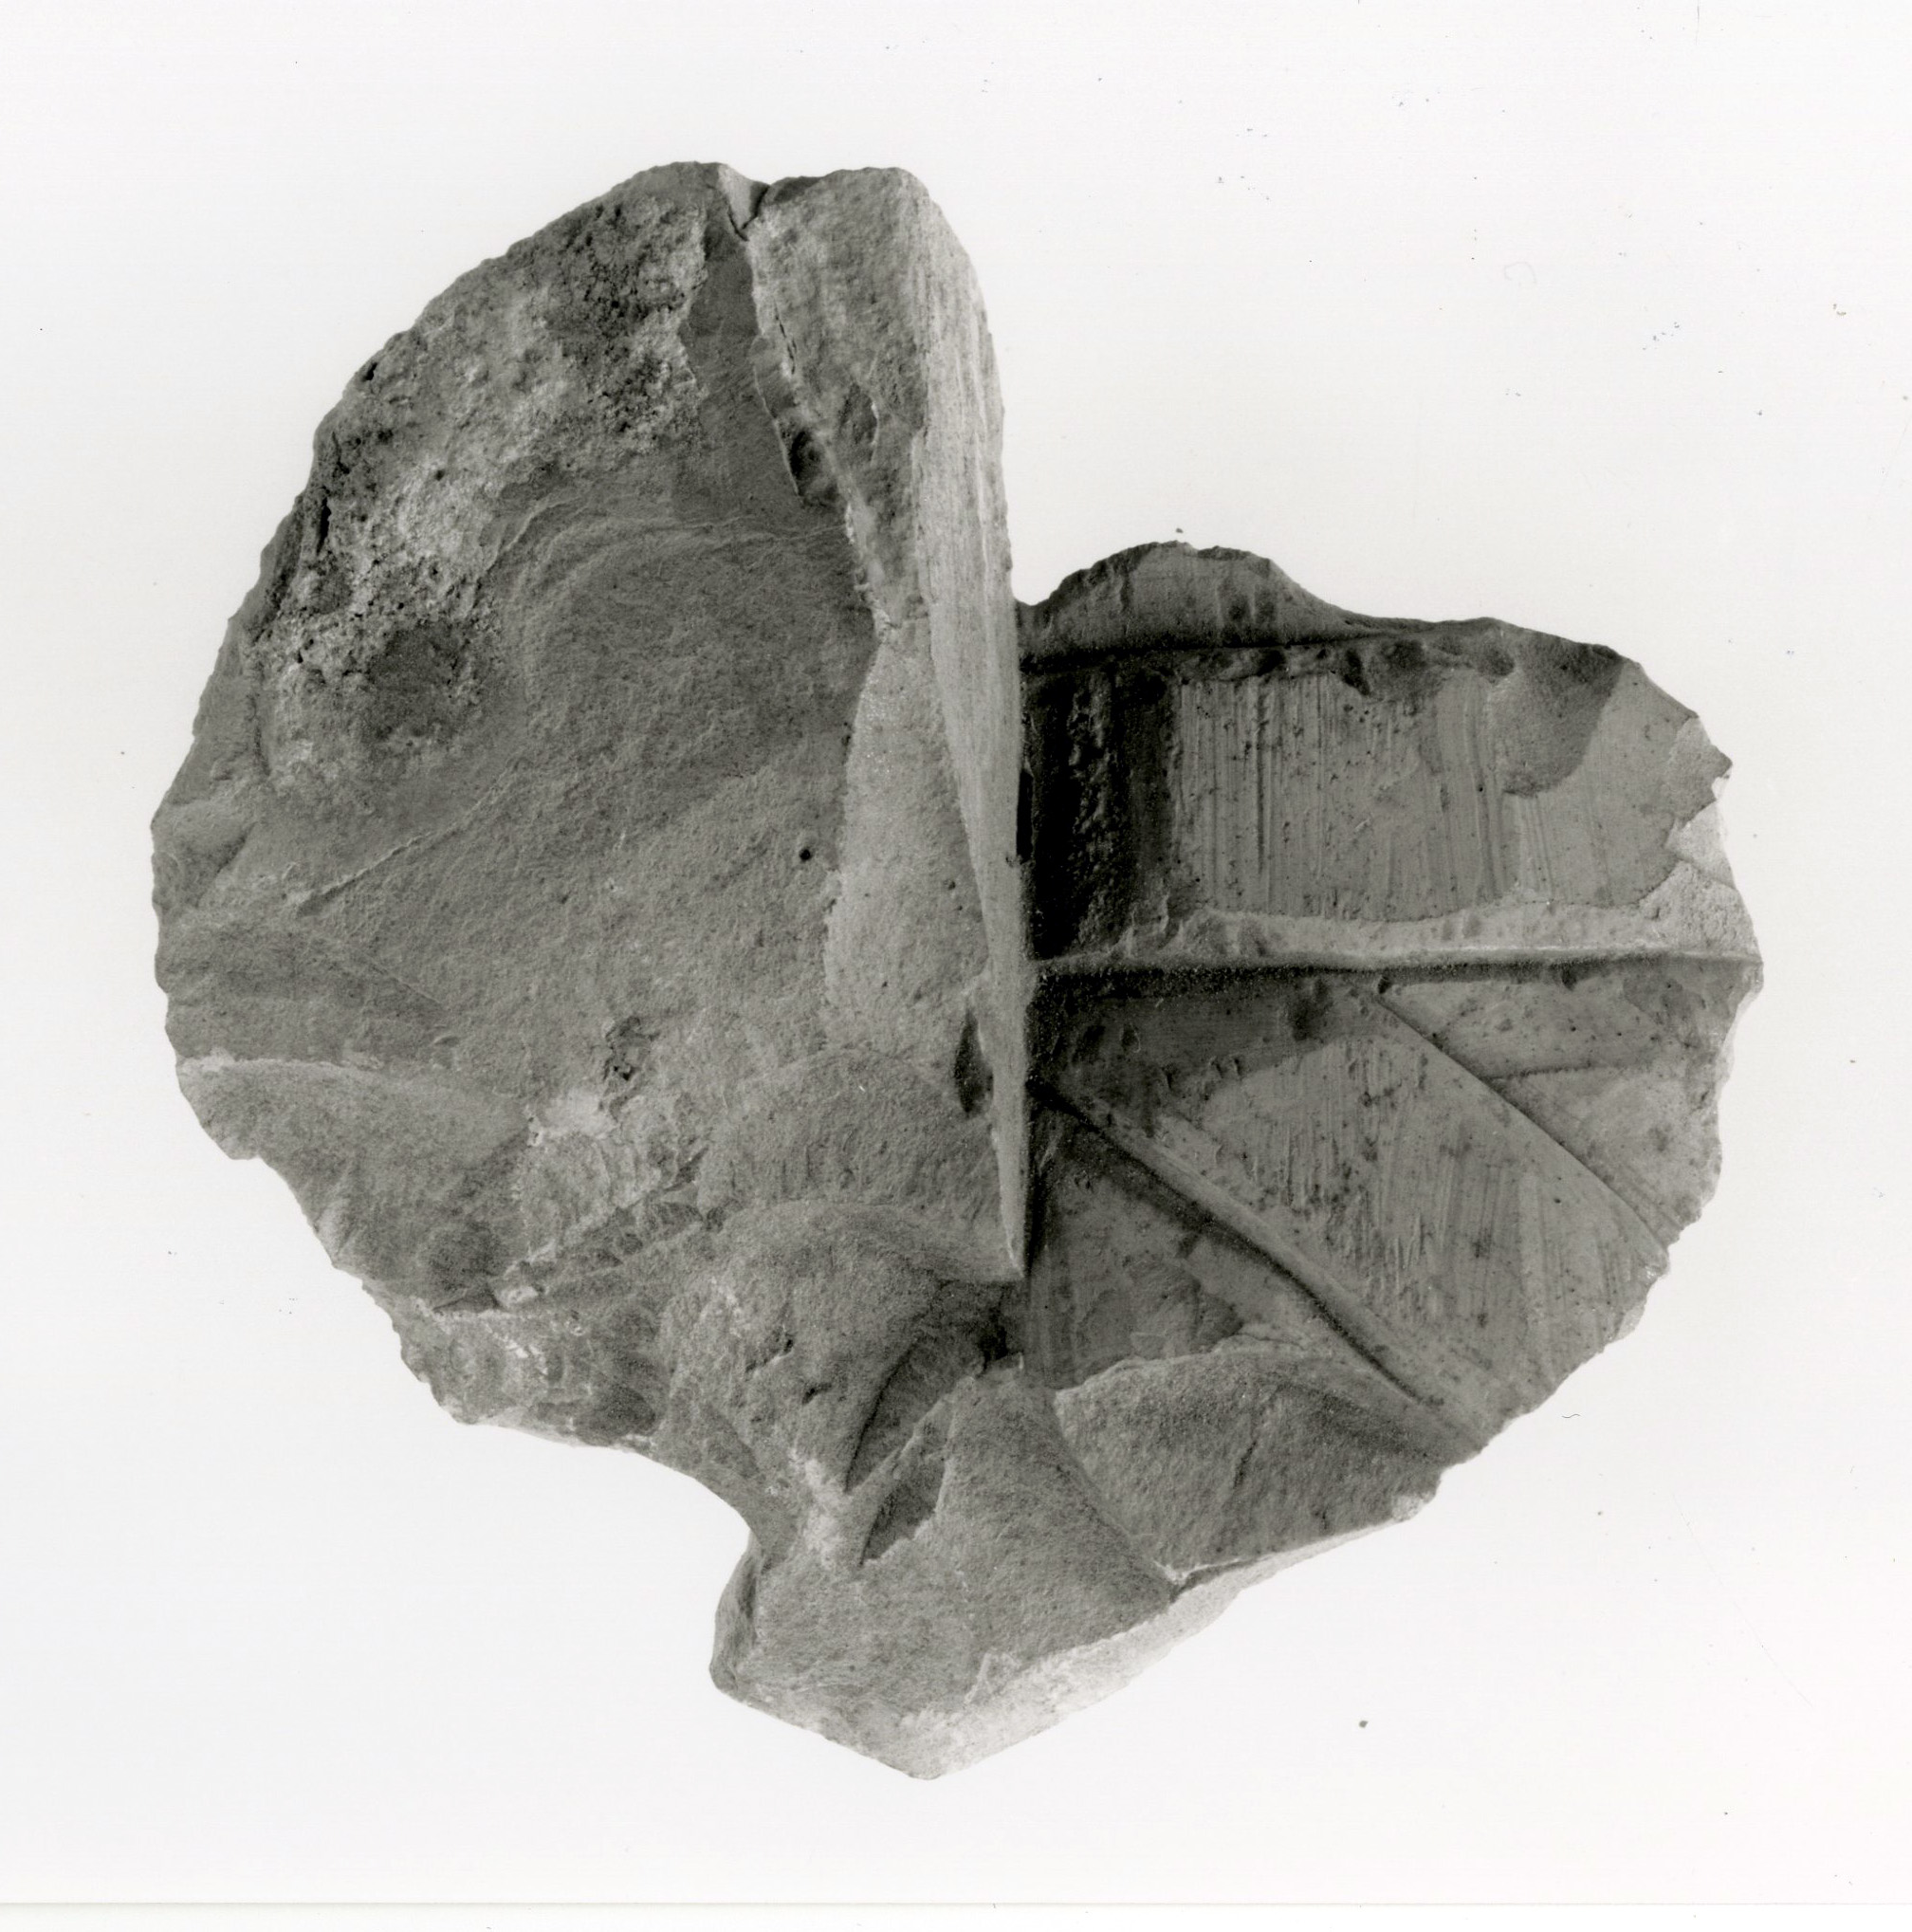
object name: relief, tomb of nespekashuty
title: Raised relief fragment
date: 664-610 BCE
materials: limestone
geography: egypt